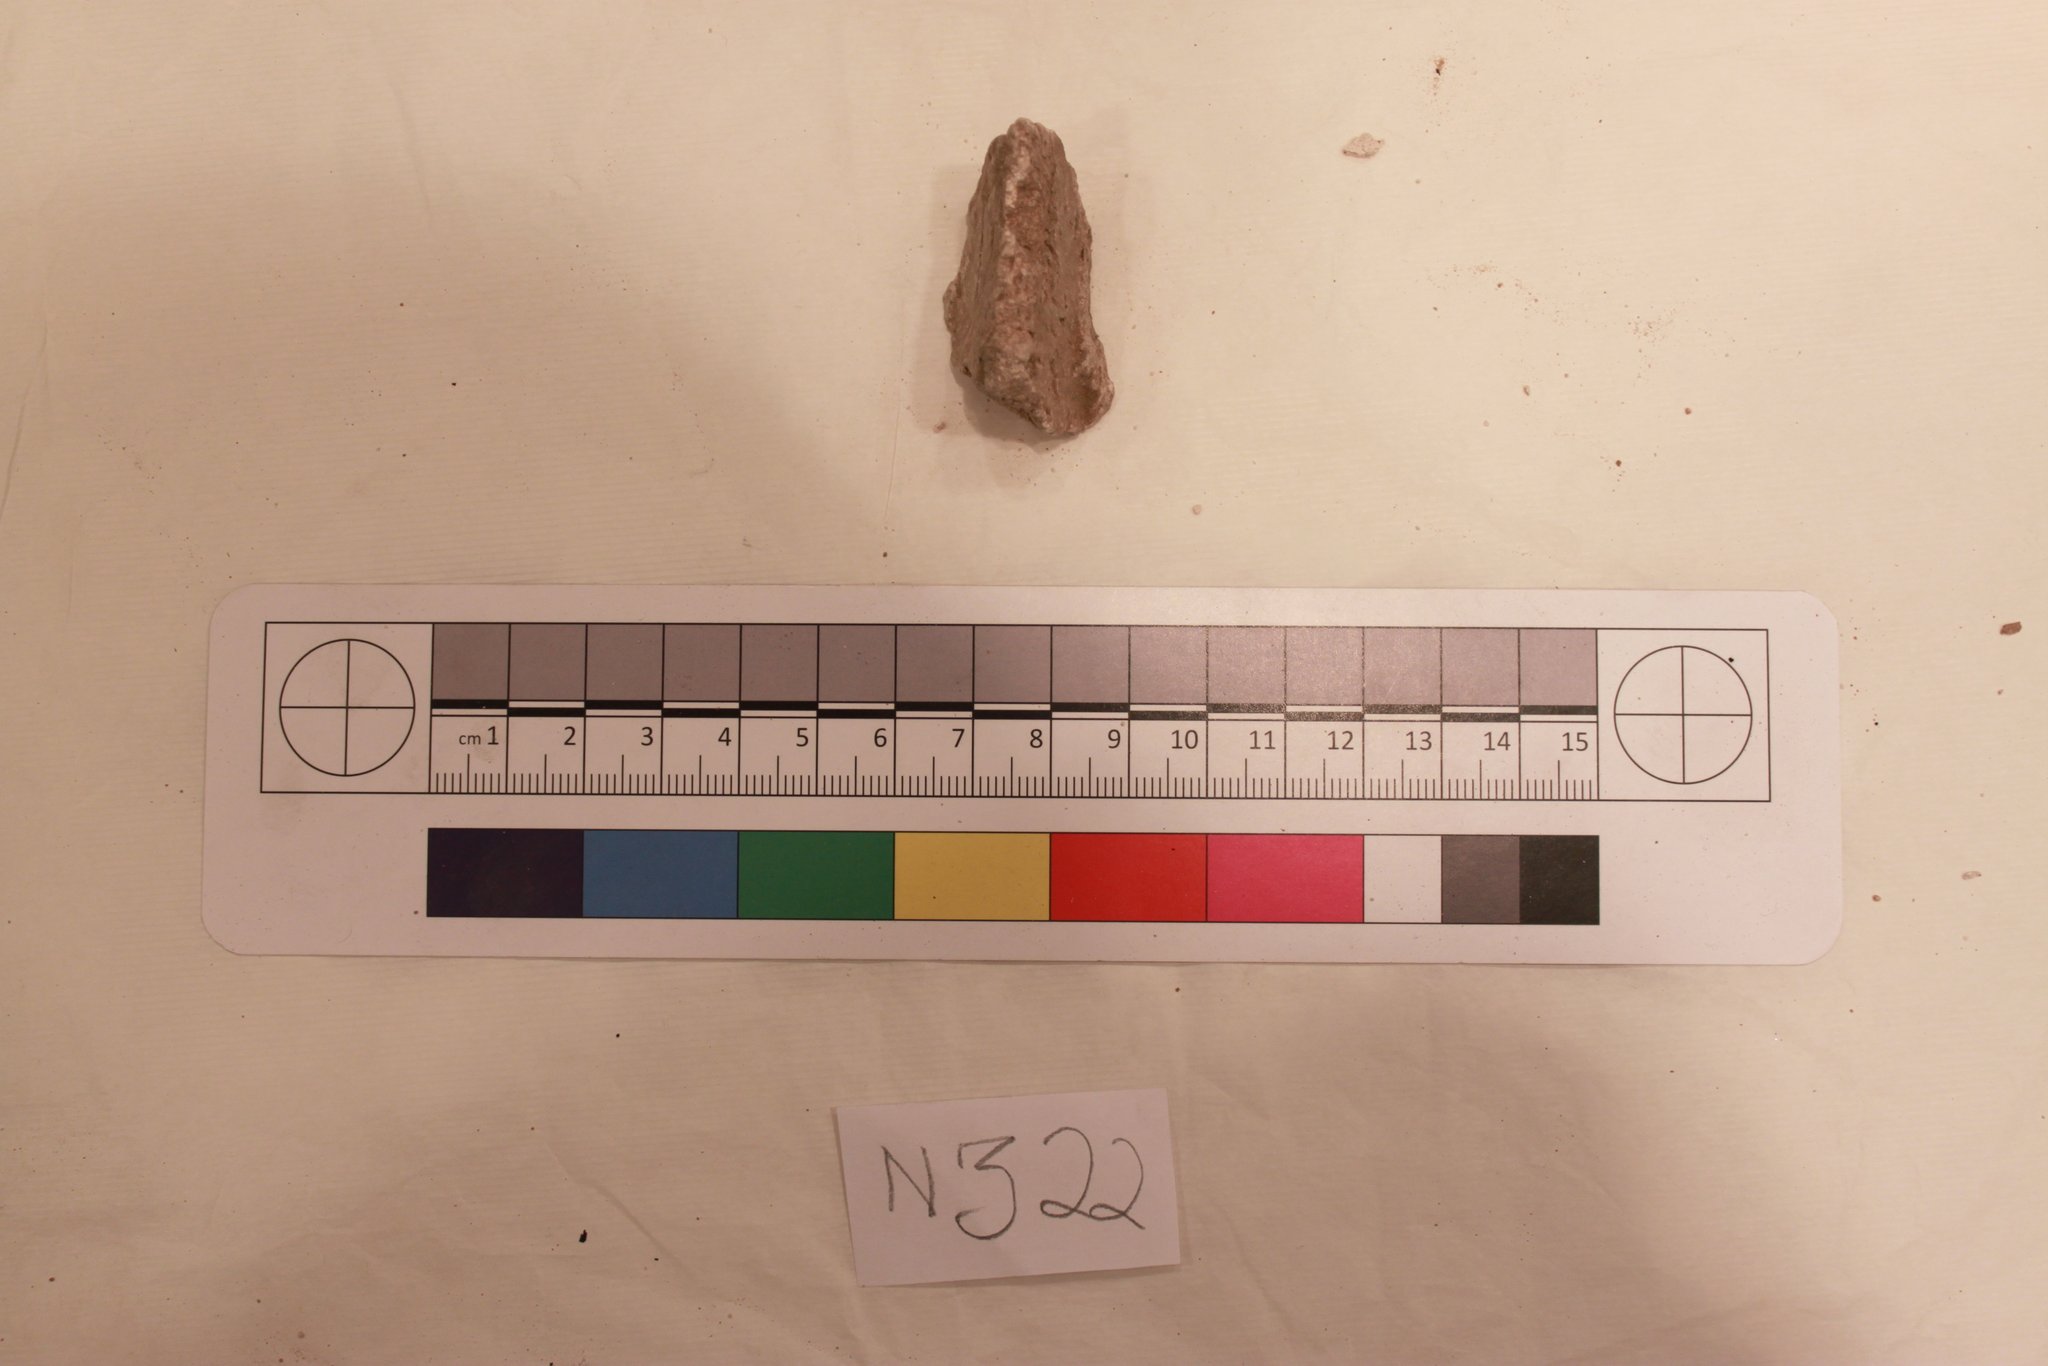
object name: fragment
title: Stucco Fragment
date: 701-1200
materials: plaster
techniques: carving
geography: iran